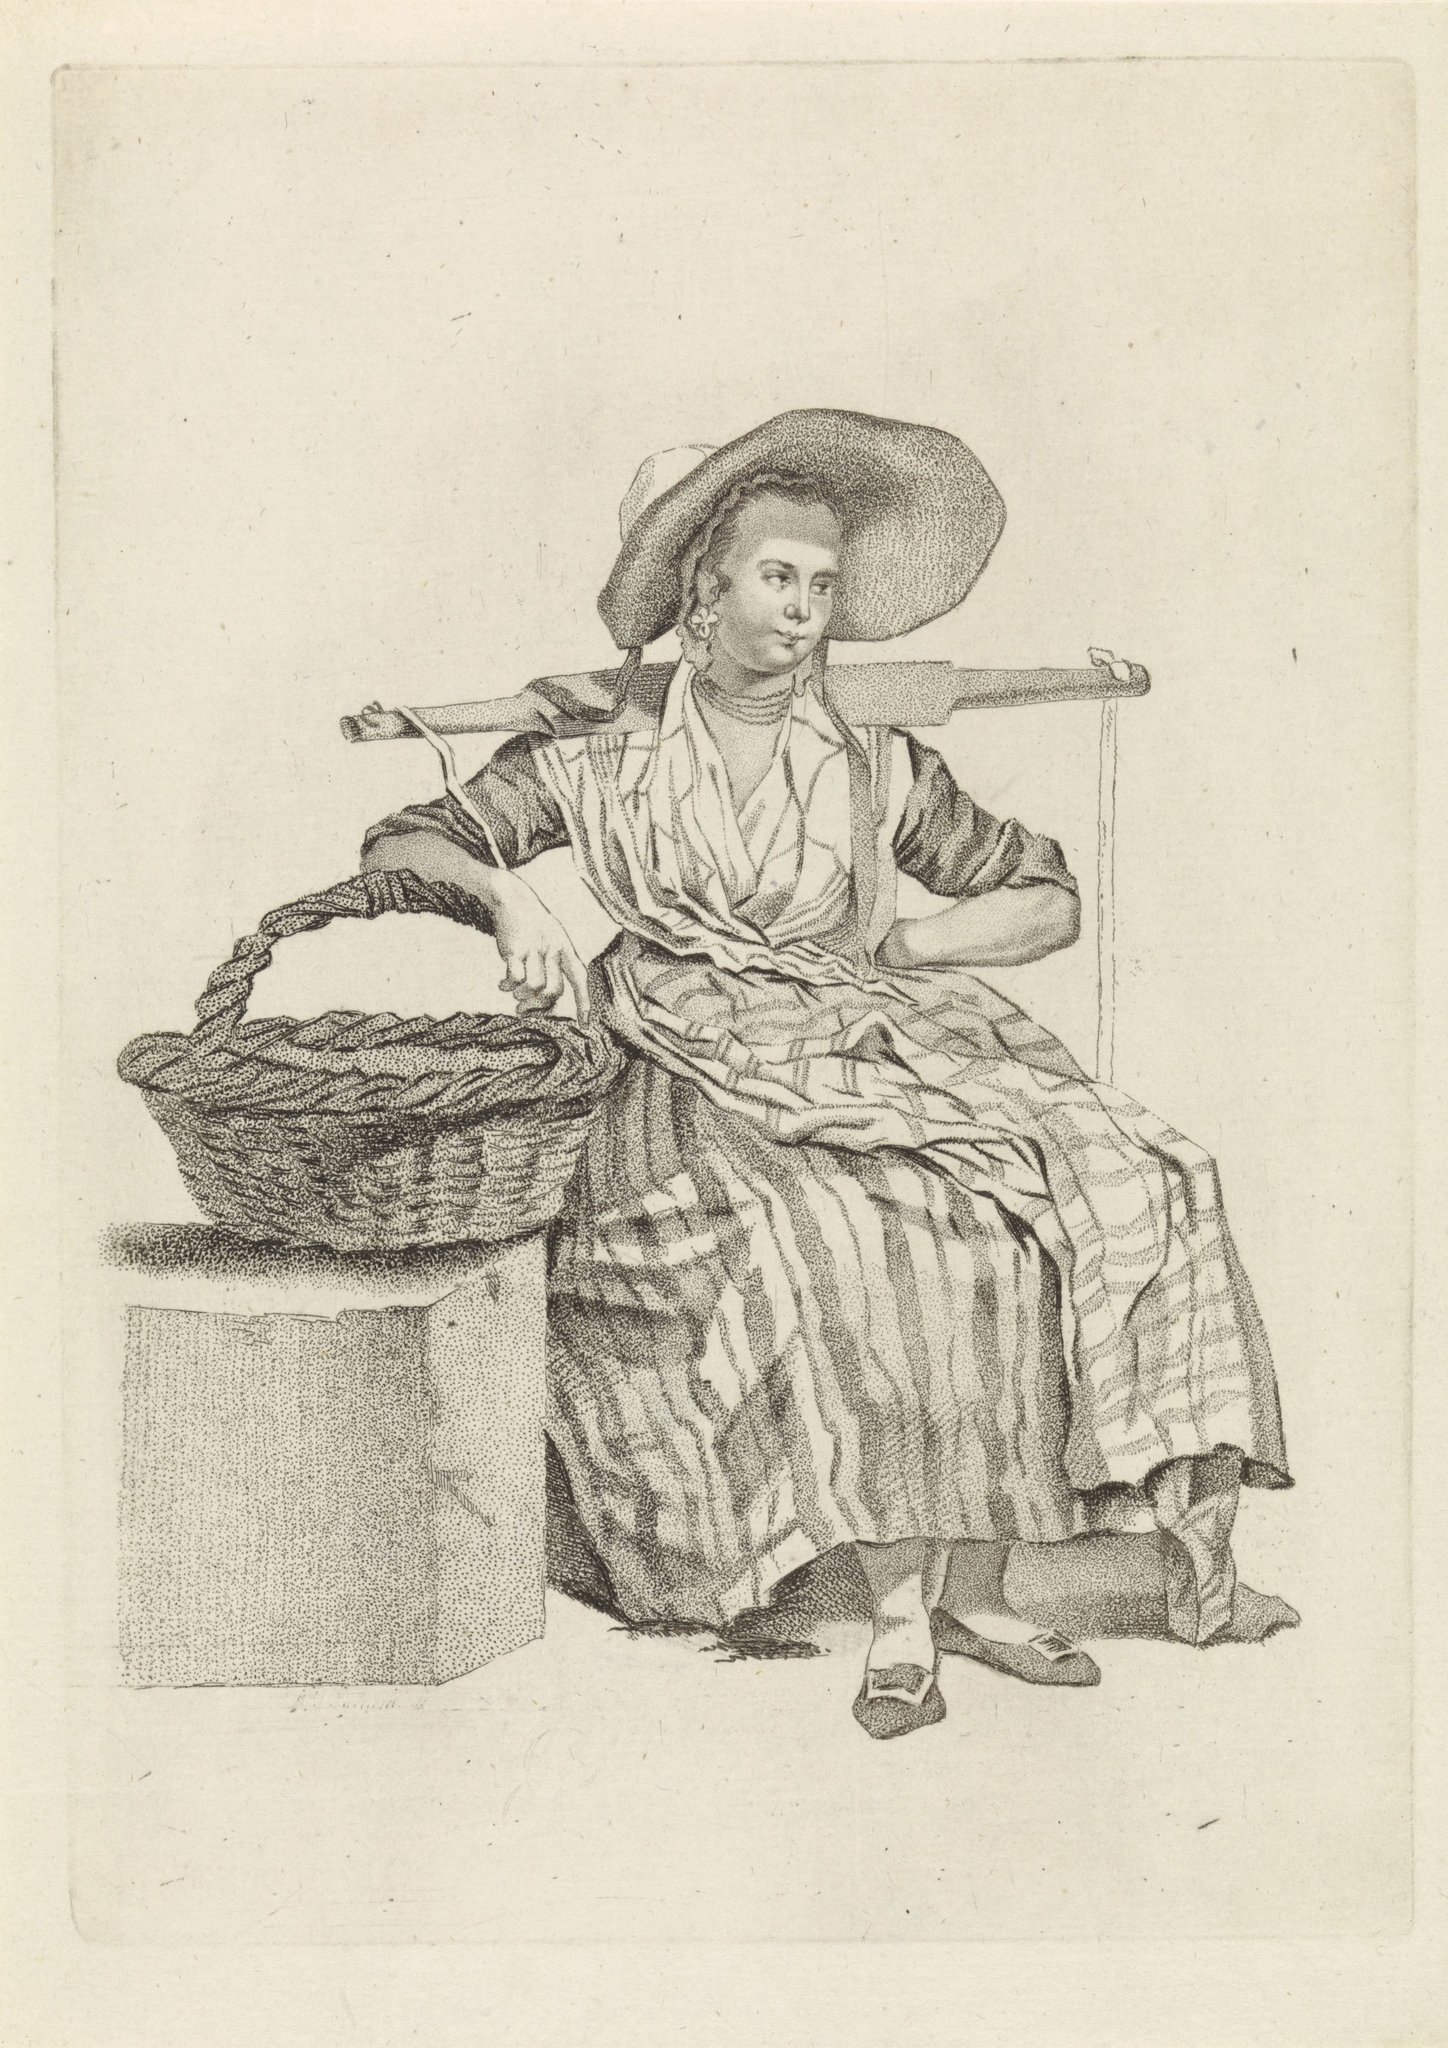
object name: print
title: Zittende boerenvrouw met mand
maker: mathias de sallieth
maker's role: print maker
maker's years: 1749-1791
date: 1772-1791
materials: paper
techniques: printmaking, etching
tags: farmers - aa - female farmer, farmer's wife, container made of plant material other than wood: basket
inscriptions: collector's mark: Lugt 2228, collector's mark: Lugt 2760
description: De prent verscheen vanaf 1818 tevens als onderdeel van een 33-delige reeks prenten door Mathias de Sallieth, samengebonden in: Perkois, Jacobus, Prins, Johannes Huibert. Verzameling van verschillende gekleede mans- en vrouwenstanden, ter oefening van jonge schilders en liefhebbers. Rotterdam: Johannes Immerzeel, 1818.